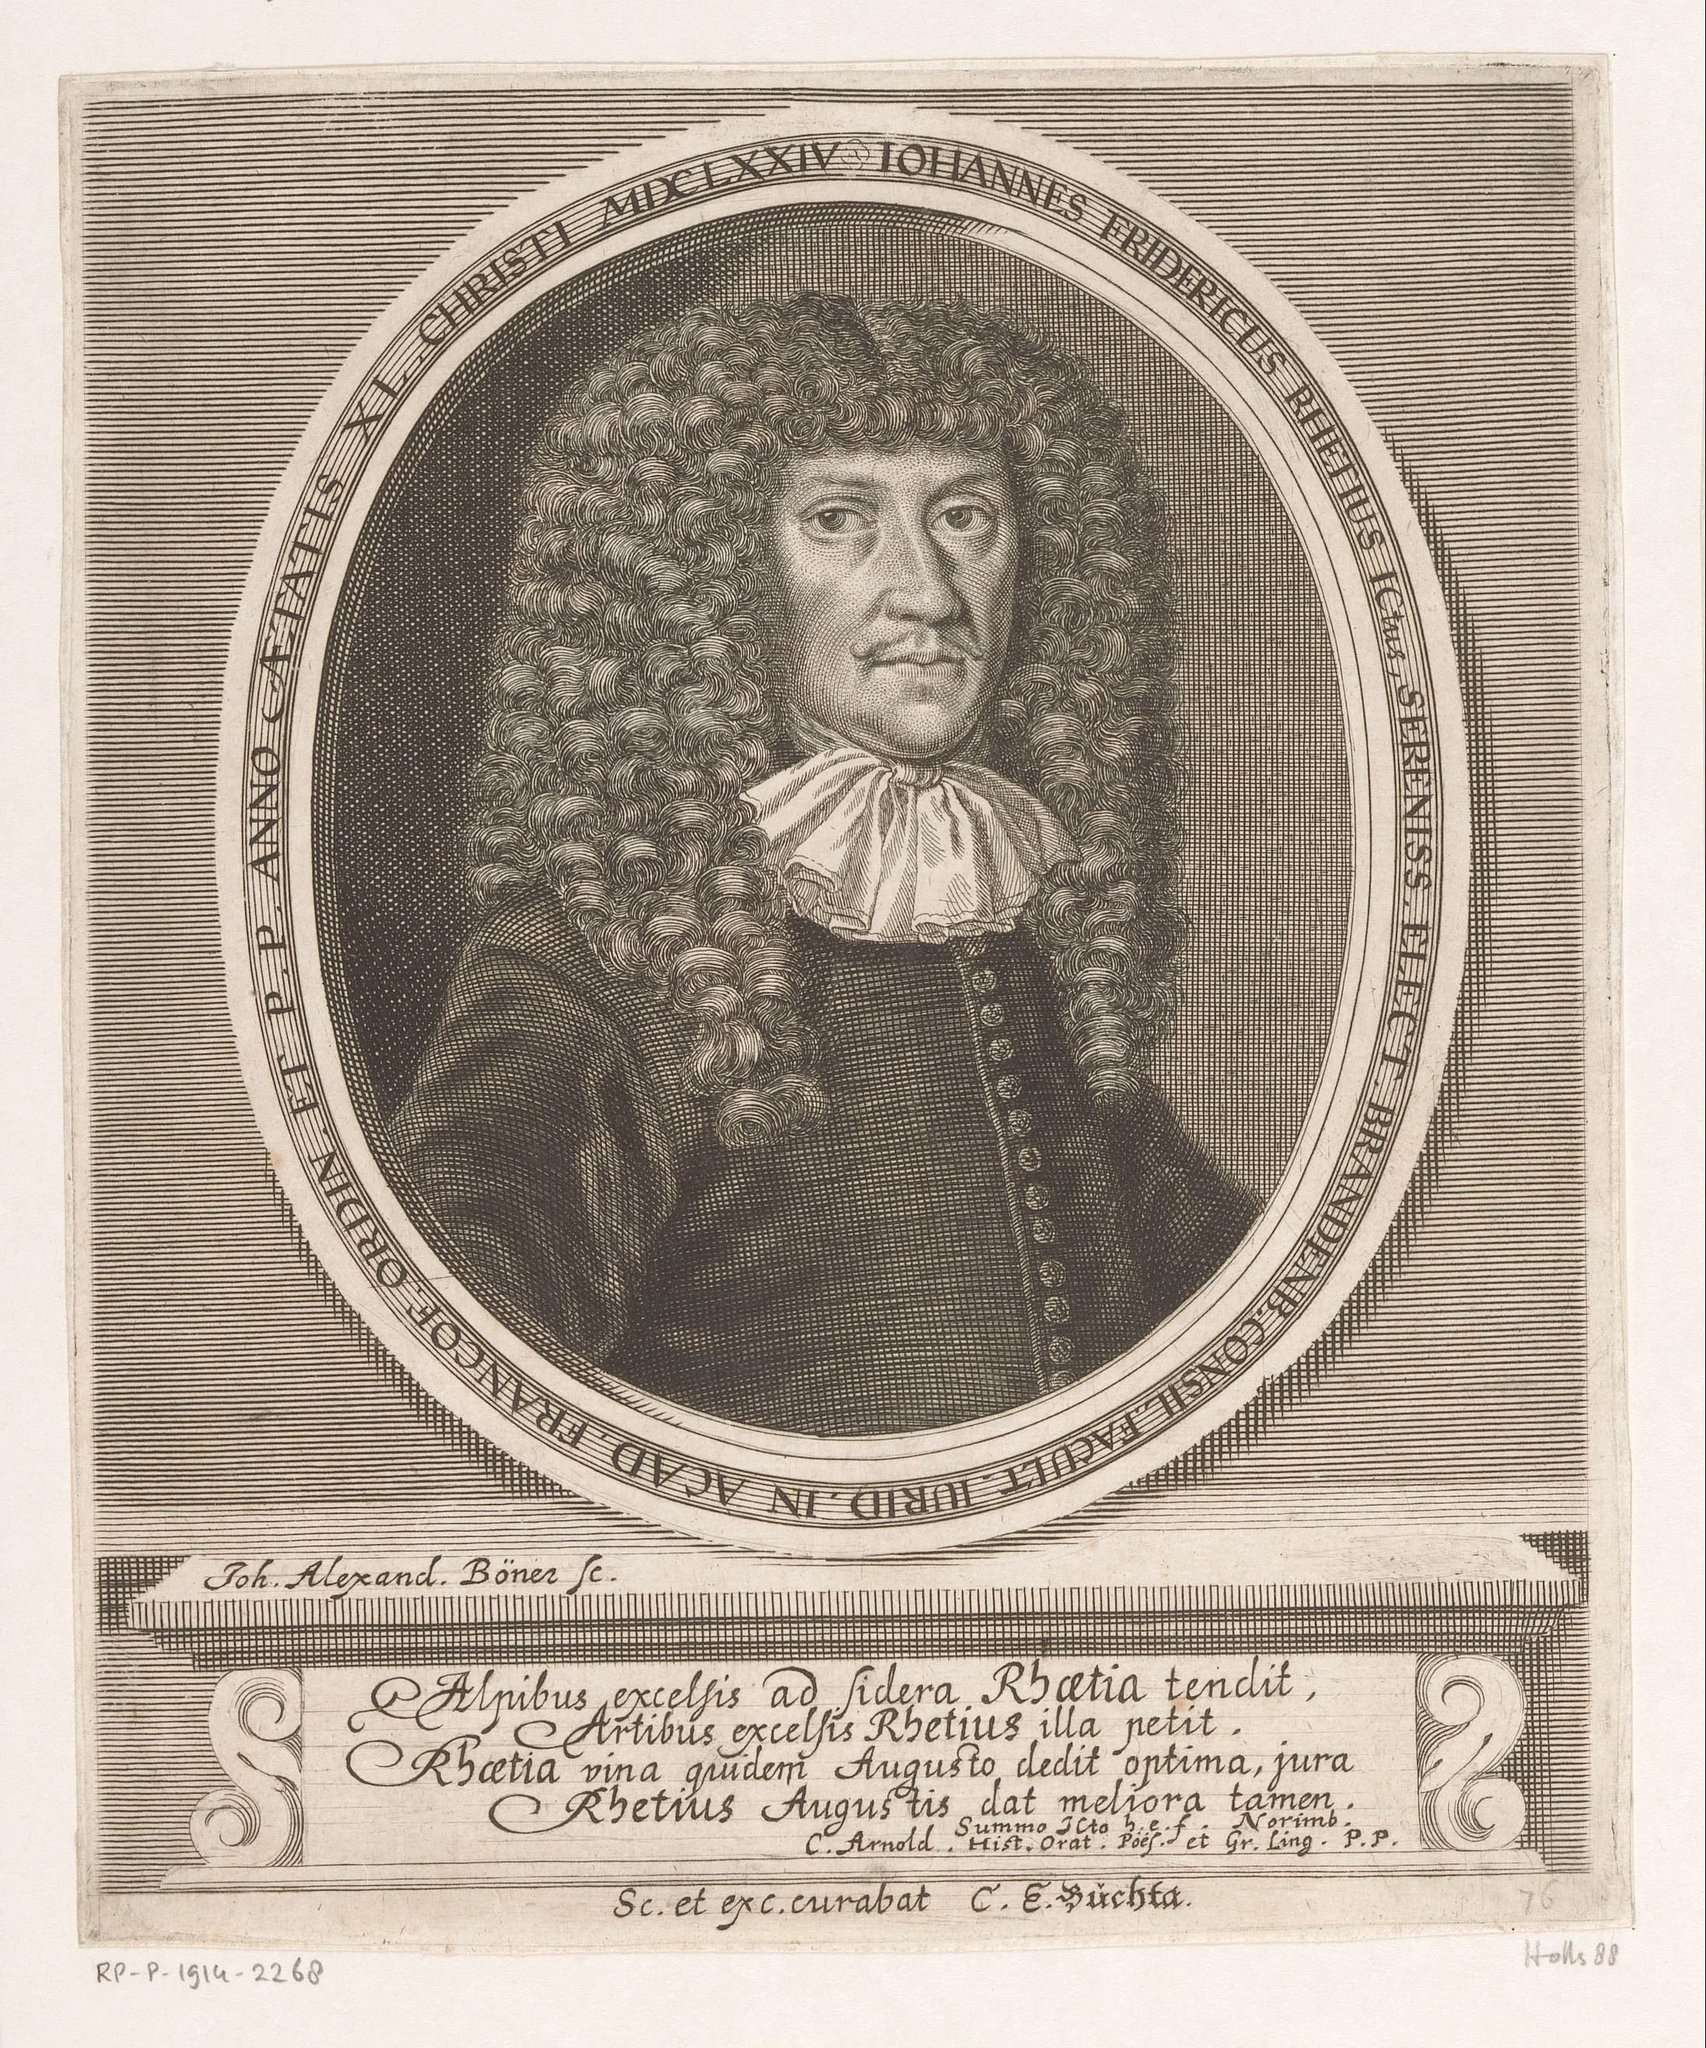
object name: print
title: Portret van Johann Friedrich Rhetz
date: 1674-1690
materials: paper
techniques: engraving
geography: nuremberg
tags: berlin, johann friedrich rhetz, historical persons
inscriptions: collector's mark: Lugt 2228